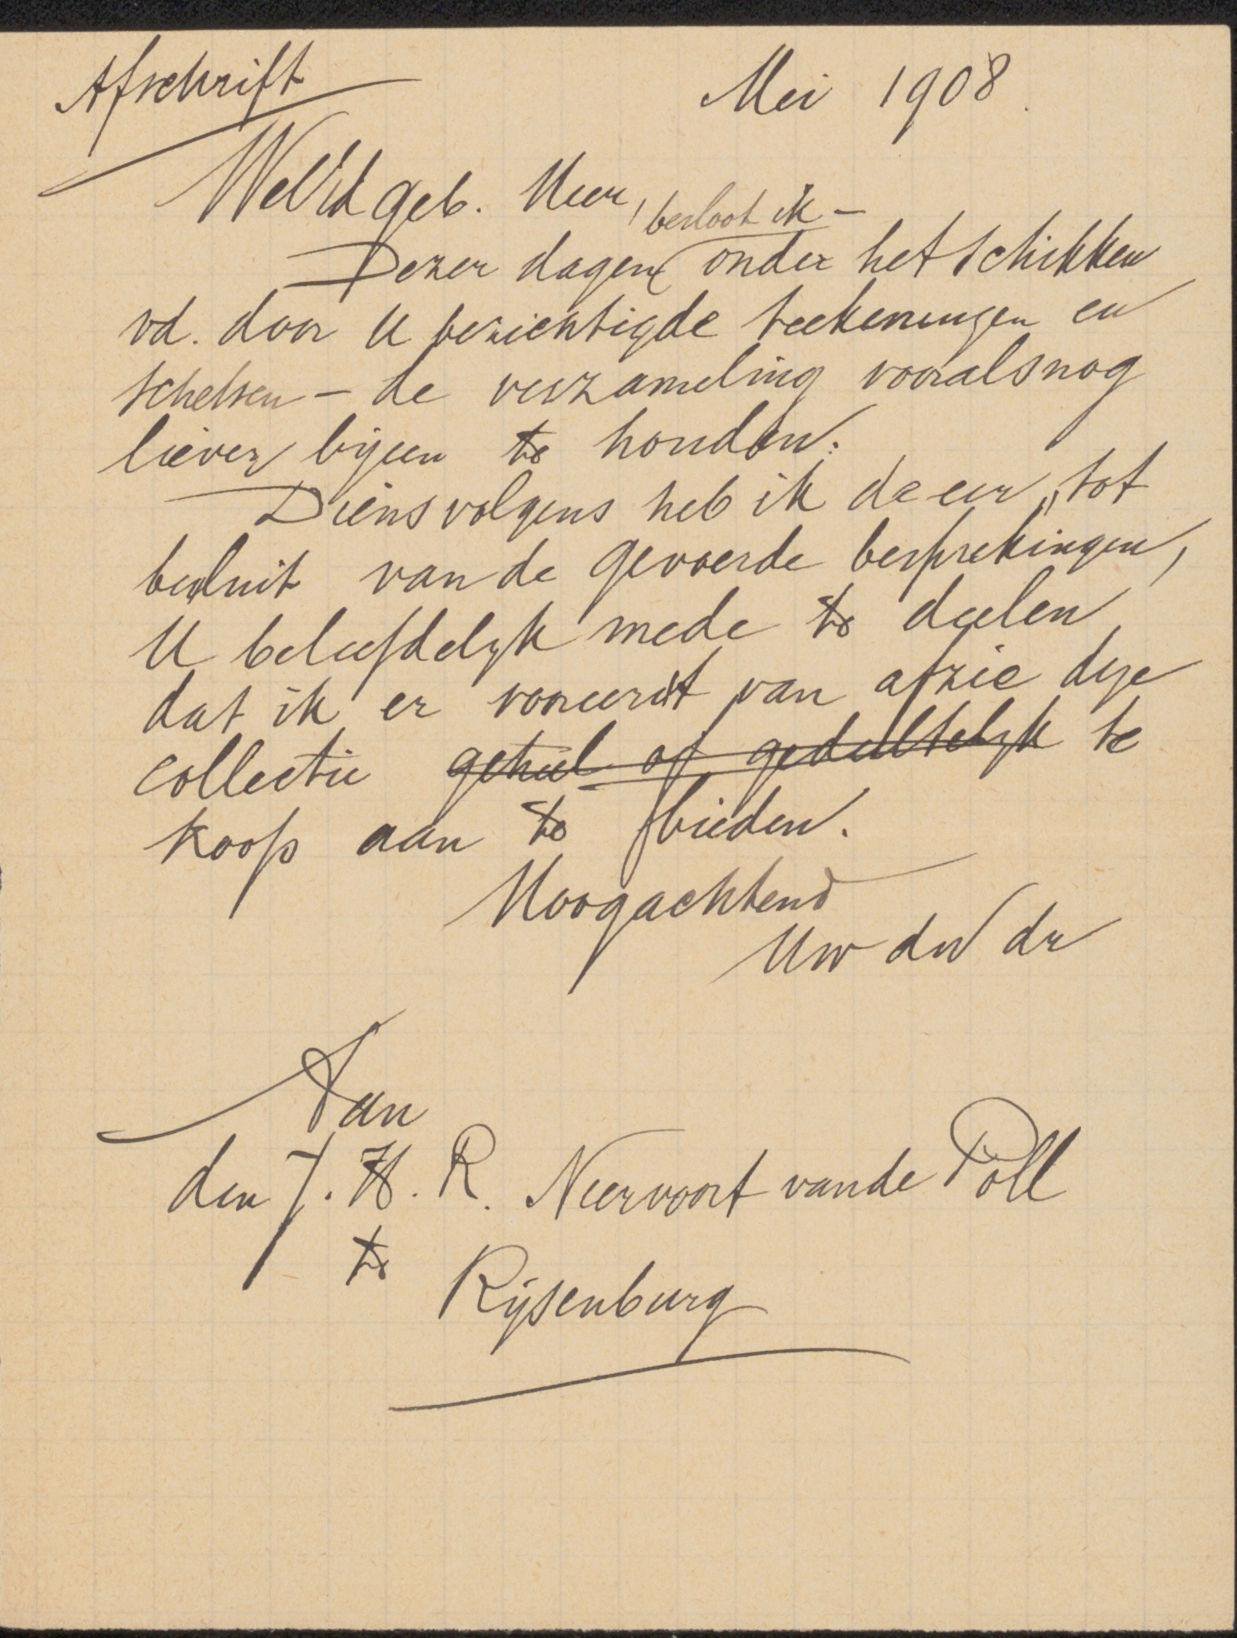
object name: letter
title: Brief aan J.R.H. Neervoort van de Poll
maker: august allebé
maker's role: draughtsman, print maker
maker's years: 1838-1927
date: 1905-1908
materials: ink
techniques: pen, writing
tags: drawing, art collecting